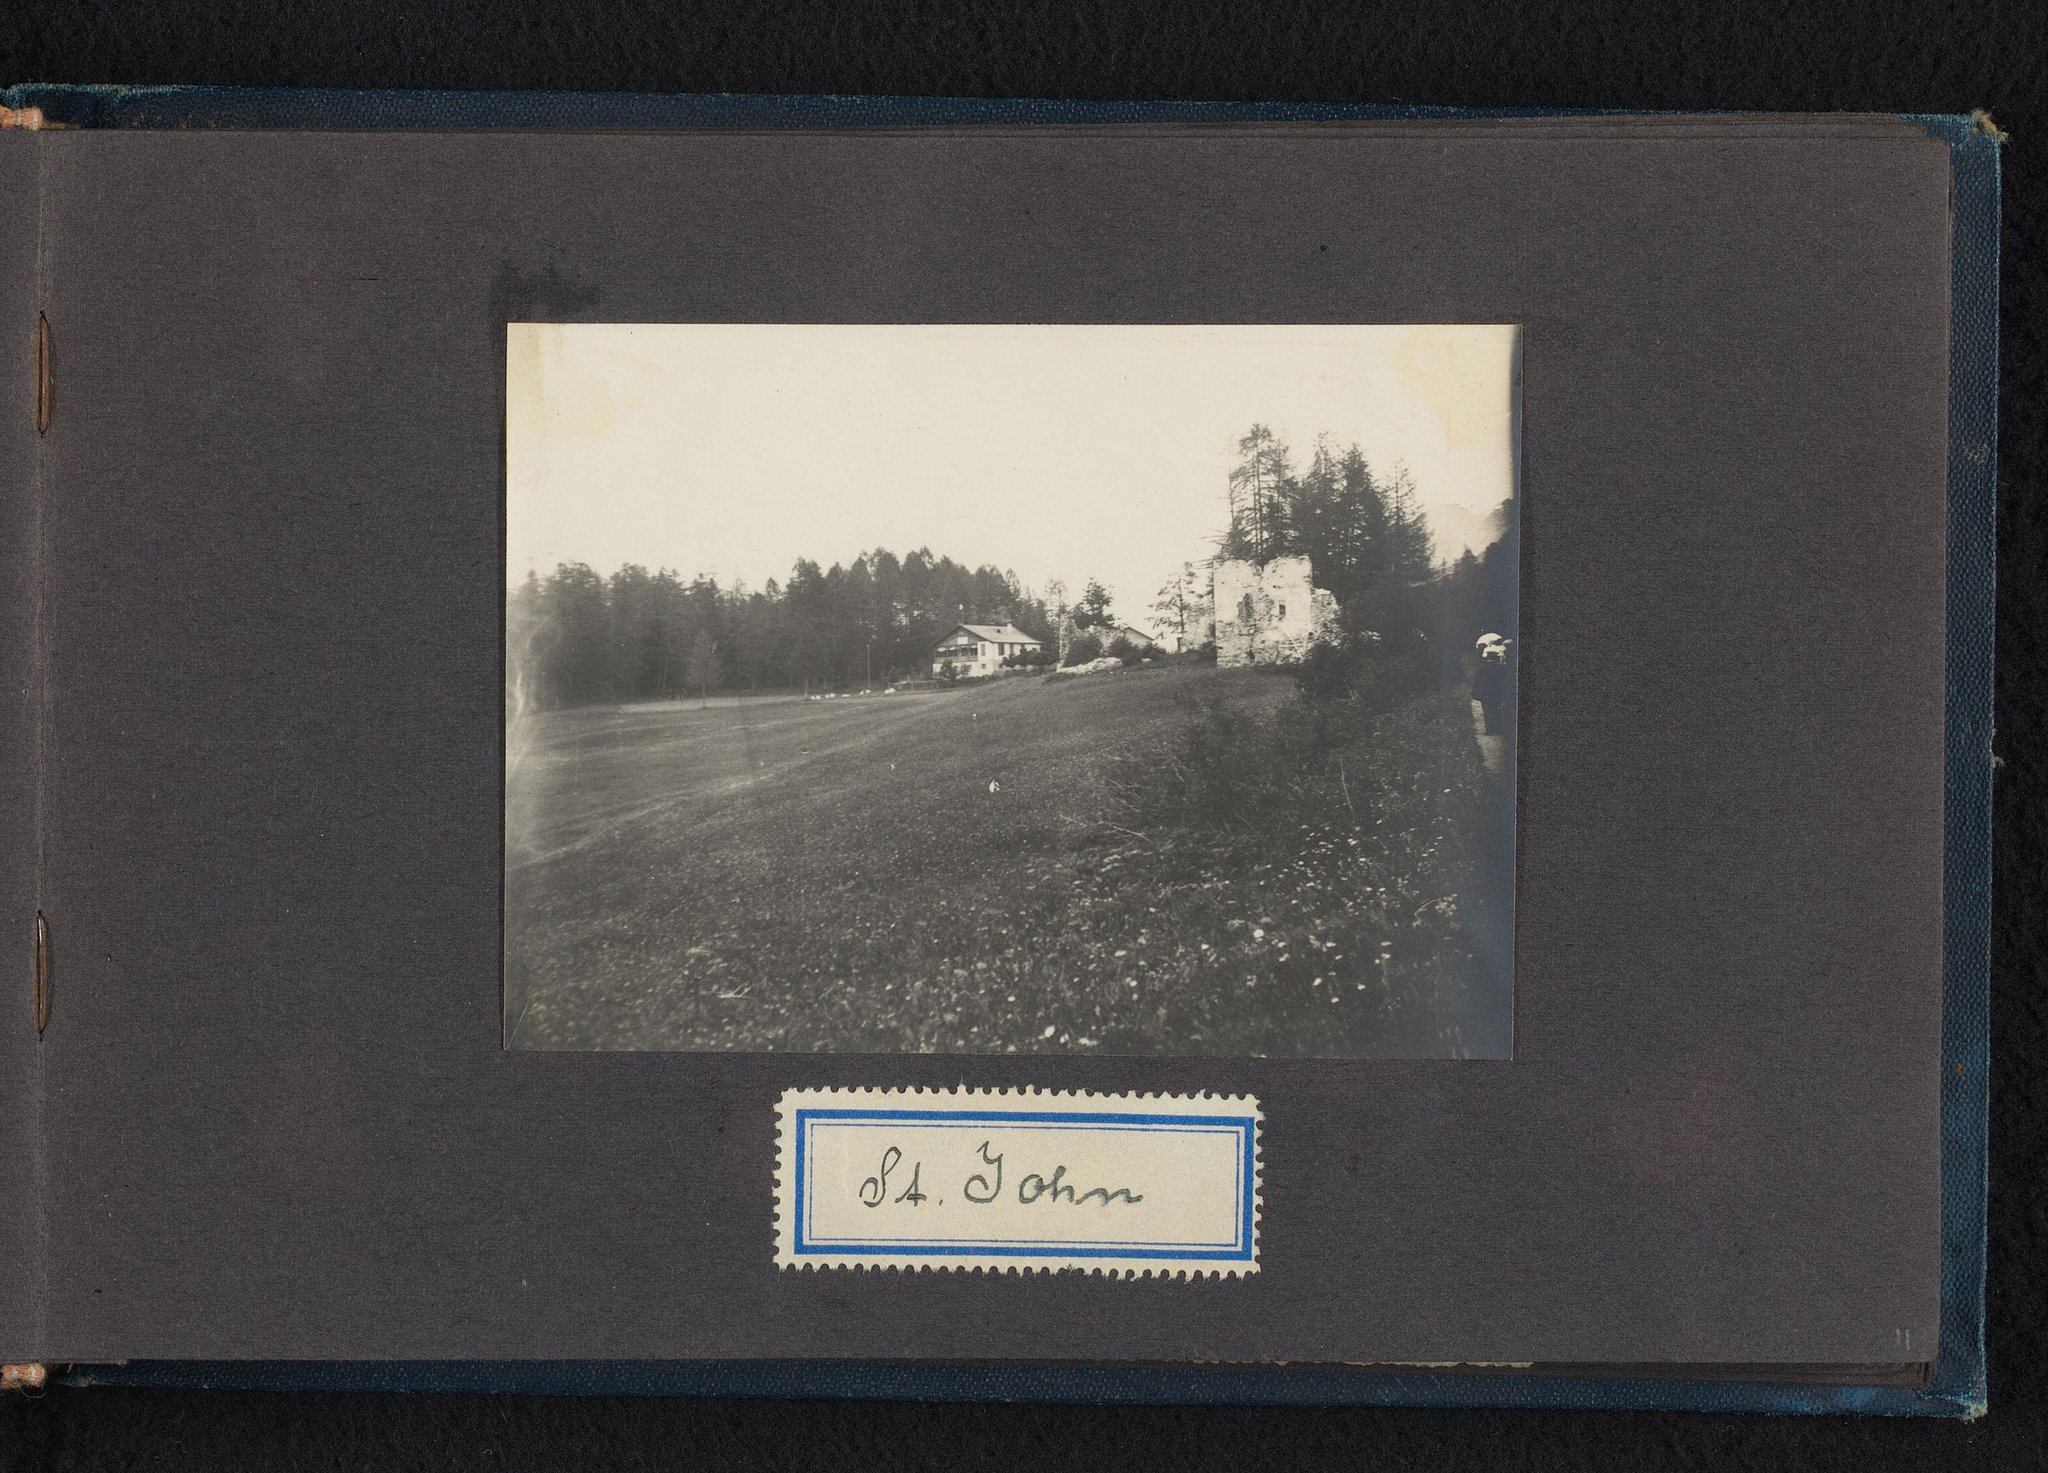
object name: photograph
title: St. John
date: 1913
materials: paper, photographic support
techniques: gelatin silver print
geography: switzerland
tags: mountain-range, snow peaks, switzerland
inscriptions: inscription: ‘St. John’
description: Albumblad met een foto van het dorp St. John, Zwitserland. Onderdeel van het fotoalbum van Else Wachenheimer-Moos en haar broers Arthur en Willy Moos en anderen in de periode 1913-1918.